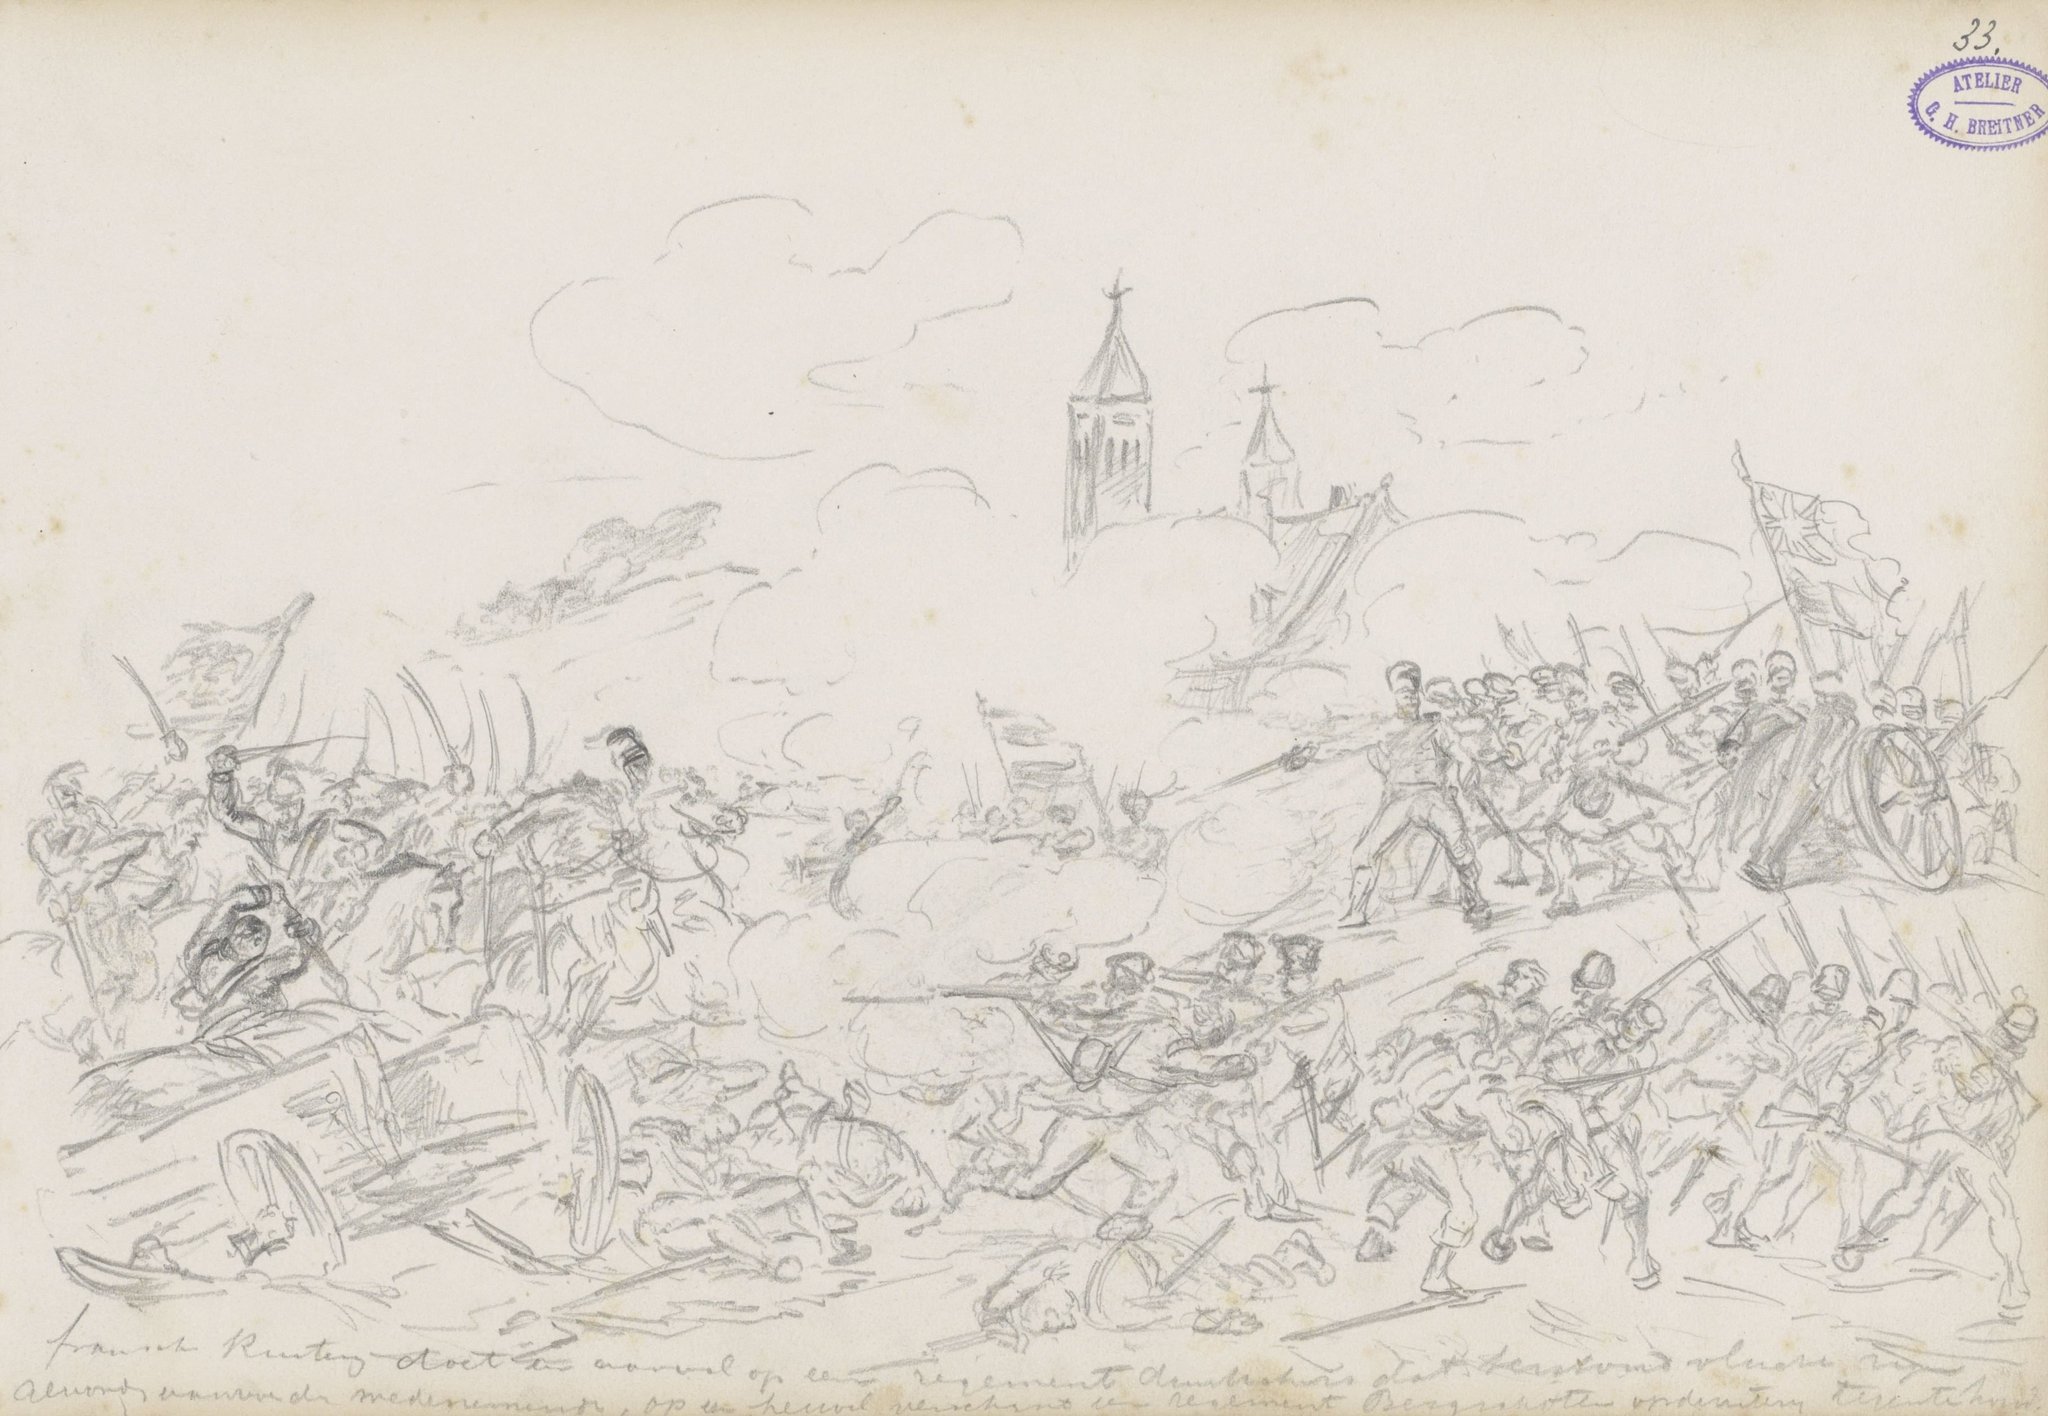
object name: drawing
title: Aanval van Franse cavaleristen op Duitse soldaten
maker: george hendrik breitner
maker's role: draughtsman, painter, print maker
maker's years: 1857-1923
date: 1872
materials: paper, pencil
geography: rotterdam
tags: (military) attack (+ during the battle), church (exterior), battle (+ cavalry, horsemen)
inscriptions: workshop stamp: Lugt 291d, annotation: ‘fransche Ruiterij doet een aanval op een regement [sic] duitschers dat terstond vlucht [...]/ [...] aanvoerder medenemende, op een heuvel verschijnt een regement Bergschutters[?] om de ruiterij tegen te houden.’, collector's mark: Lugt 2228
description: Deze tekening heeft oorspronkelijk als blad 33 deel uitgemaakt van een schetsboek. Zie voor dit schetsboek het gerelateerd object.